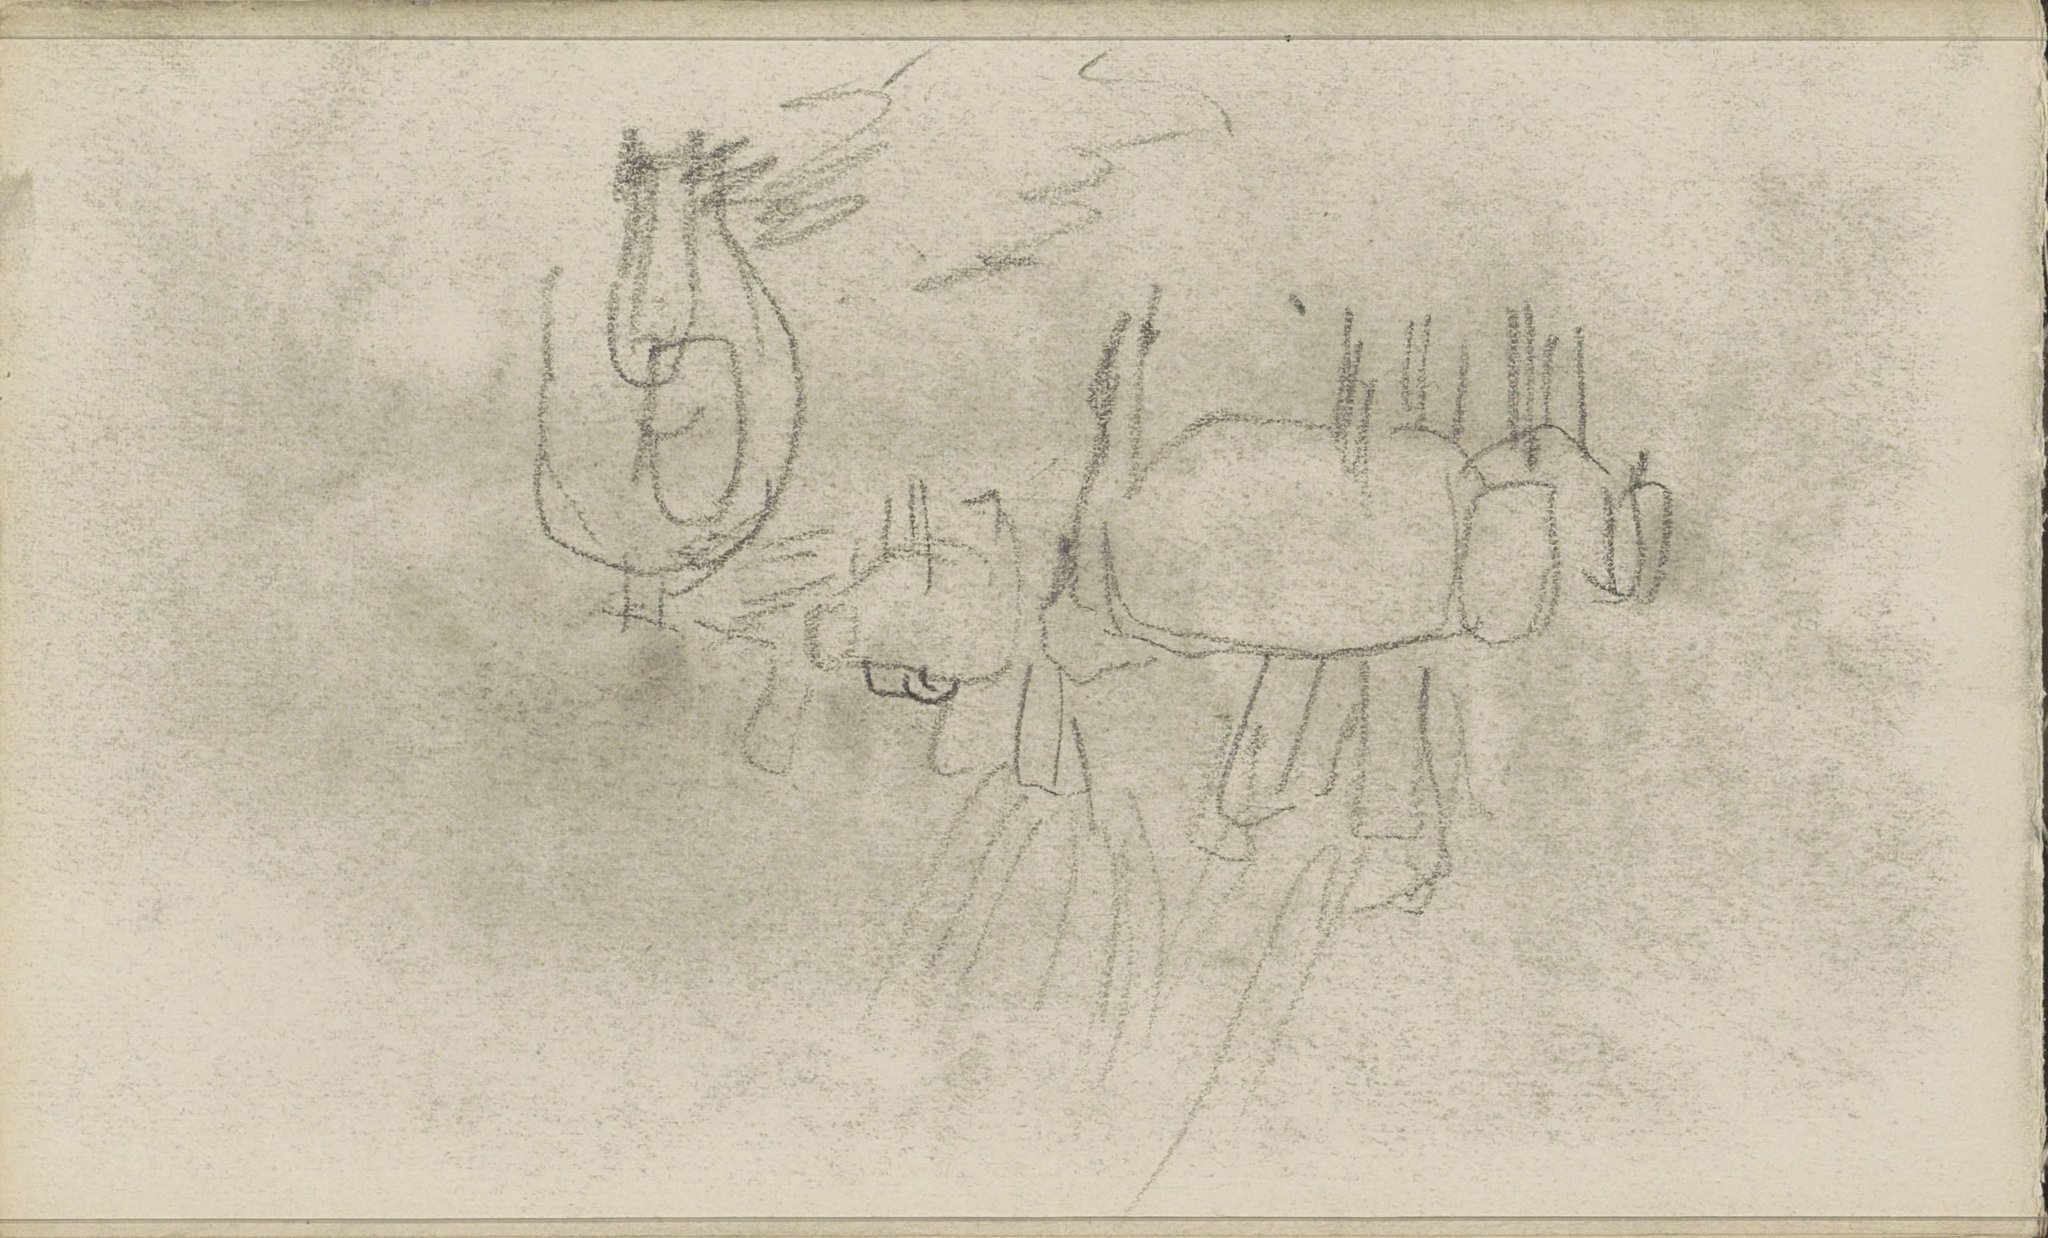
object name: sketchbook leaf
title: Koeien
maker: anton mauve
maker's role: draughtsman, painter, print maker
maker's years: 1838-1888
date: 1848-1888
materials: chalk, paper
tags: cow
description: Blad 11 verso uit een schetsboek met 33 bladen.